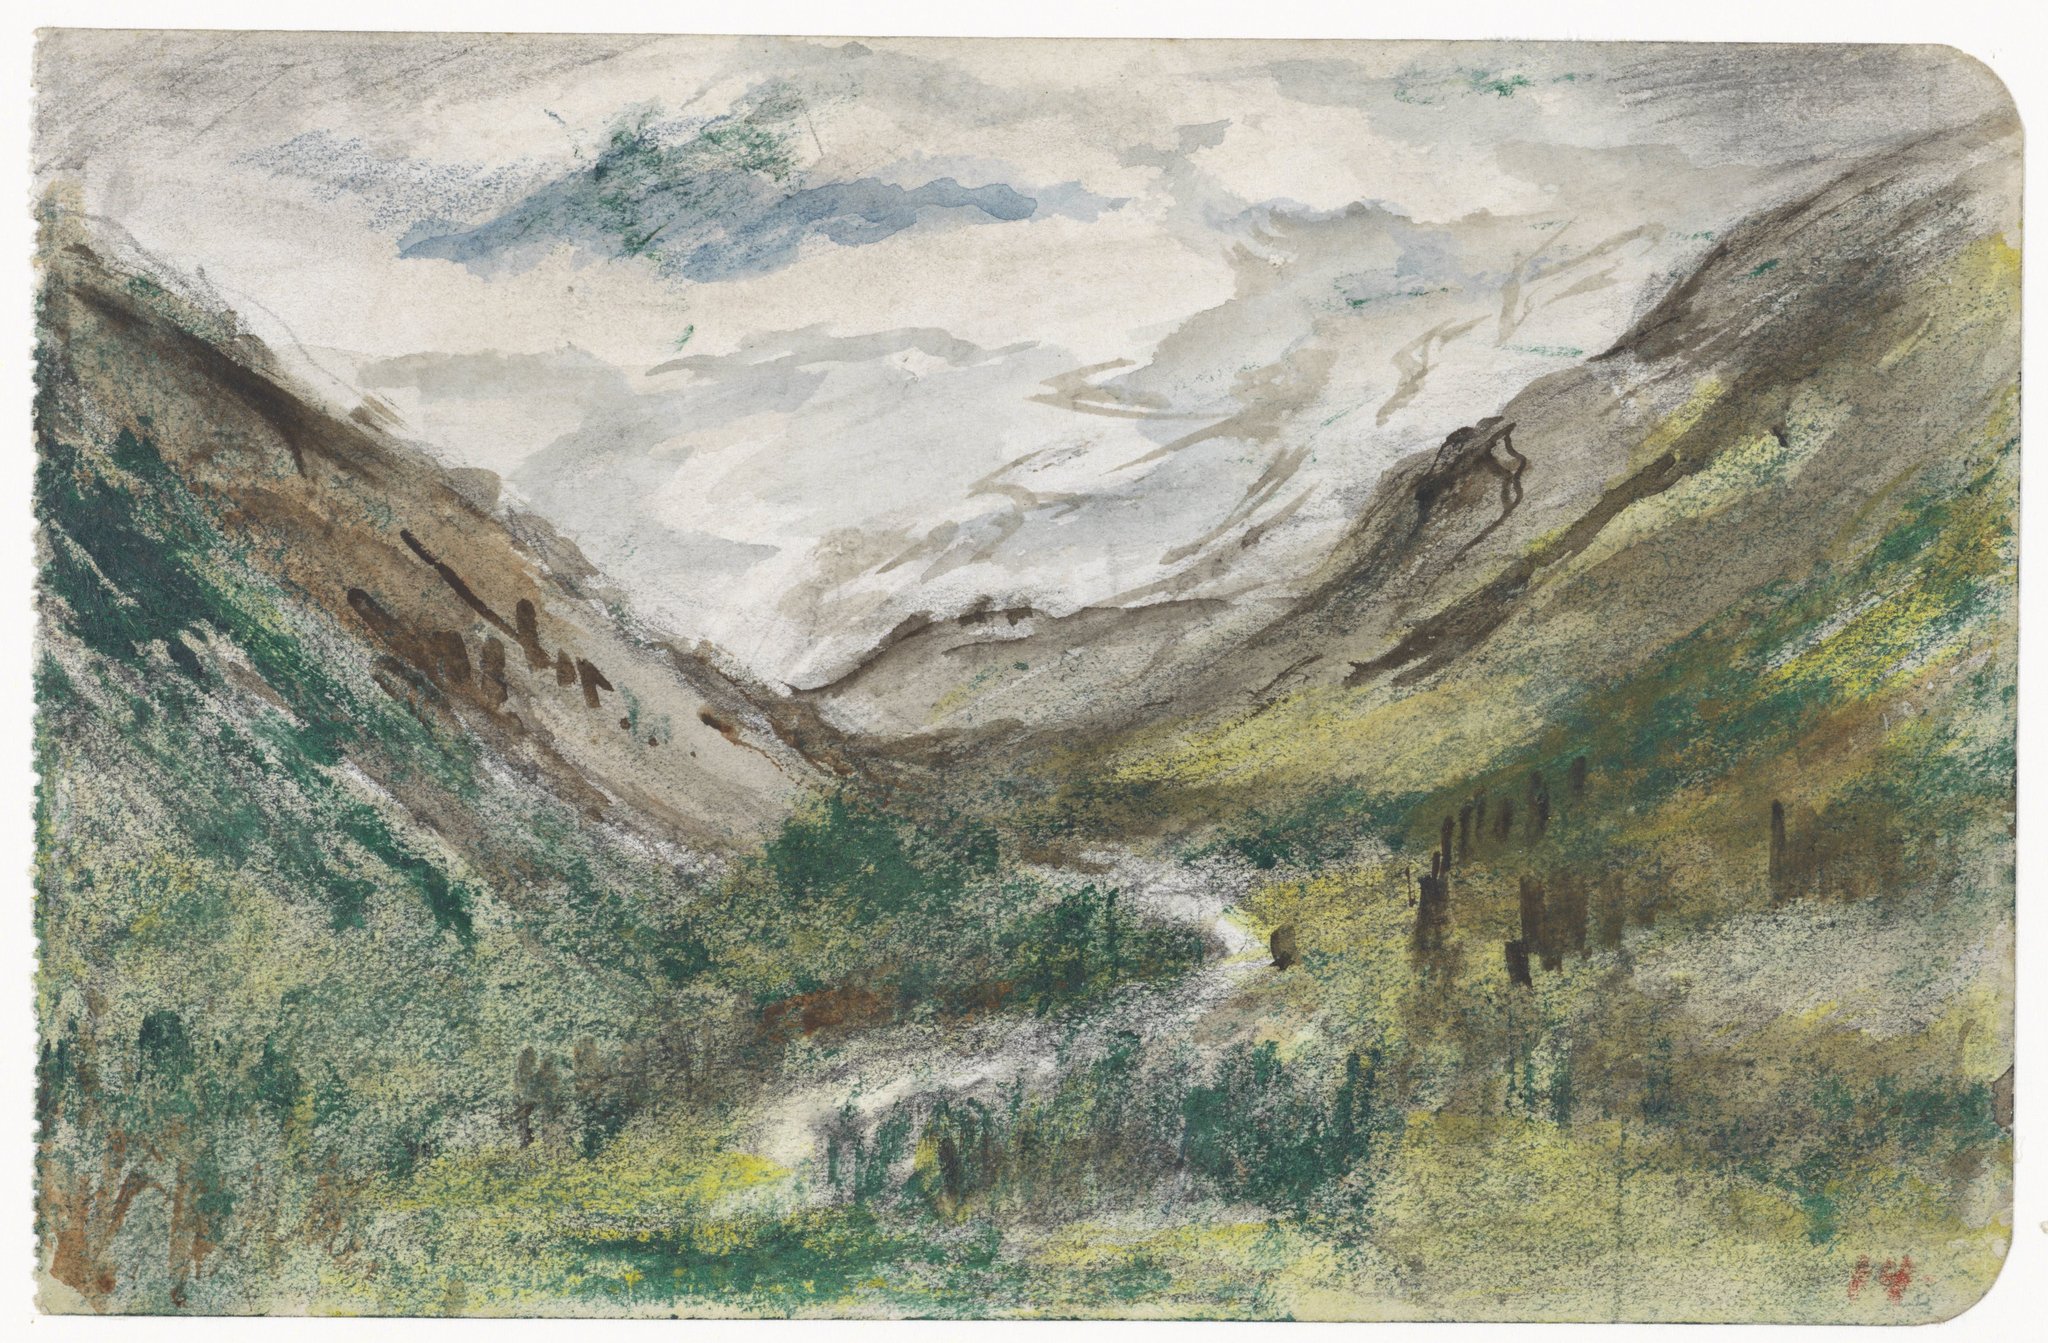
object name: drawing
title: Dal met begroeide bergen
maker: jozef israëls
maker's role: draughtsman, painter, print maker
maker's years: 1824-1911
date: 1834-1911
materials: chalk, paper, watercolor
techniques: brush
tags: mountains